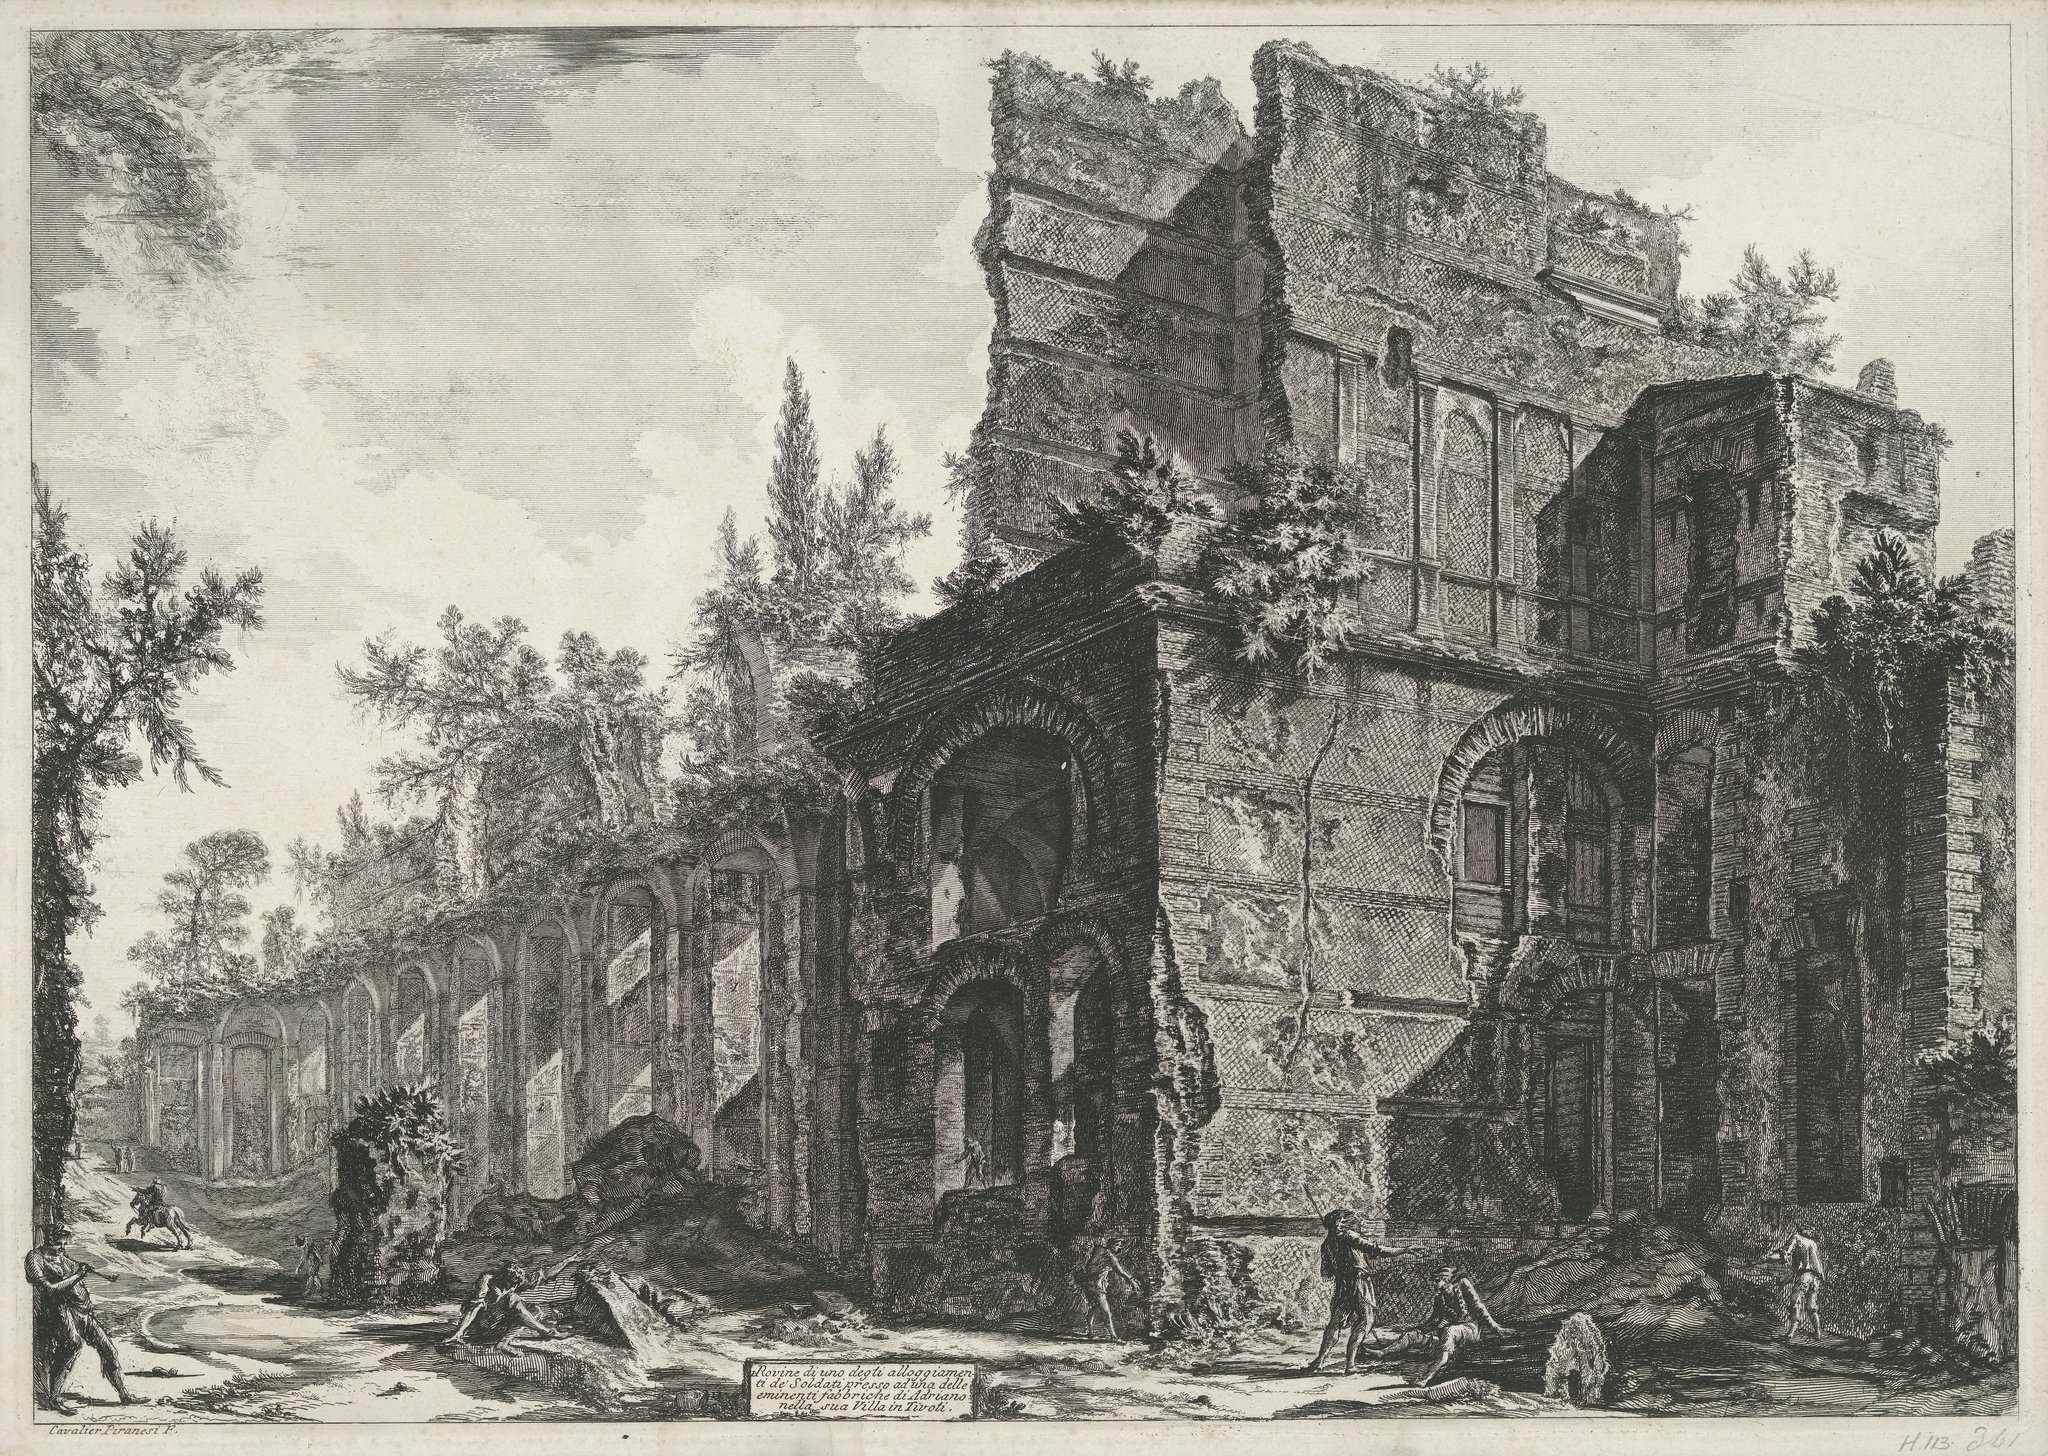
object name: print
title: Pretorio in de Villa Adriana te Tivoli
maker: giovanni battista piranesi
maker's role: designer, draughtsman, print maker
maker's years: 1720-1778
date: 1748-1778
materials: paper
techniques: etching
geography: rome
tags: villa - aa - civic architecture: inside, landscape with ruins, tivoli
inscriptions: collector's mark: Lugt 2228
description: Deze prent maakt deel uit van de serie 'Vedute di Roma'. Piranesi werkte aan deze 135 platen tellende serie tussen 1748 en zijn dood in 1778. Francesco Piranesi voegde later nog twee prenten toe aan de reeks van zijn vader.